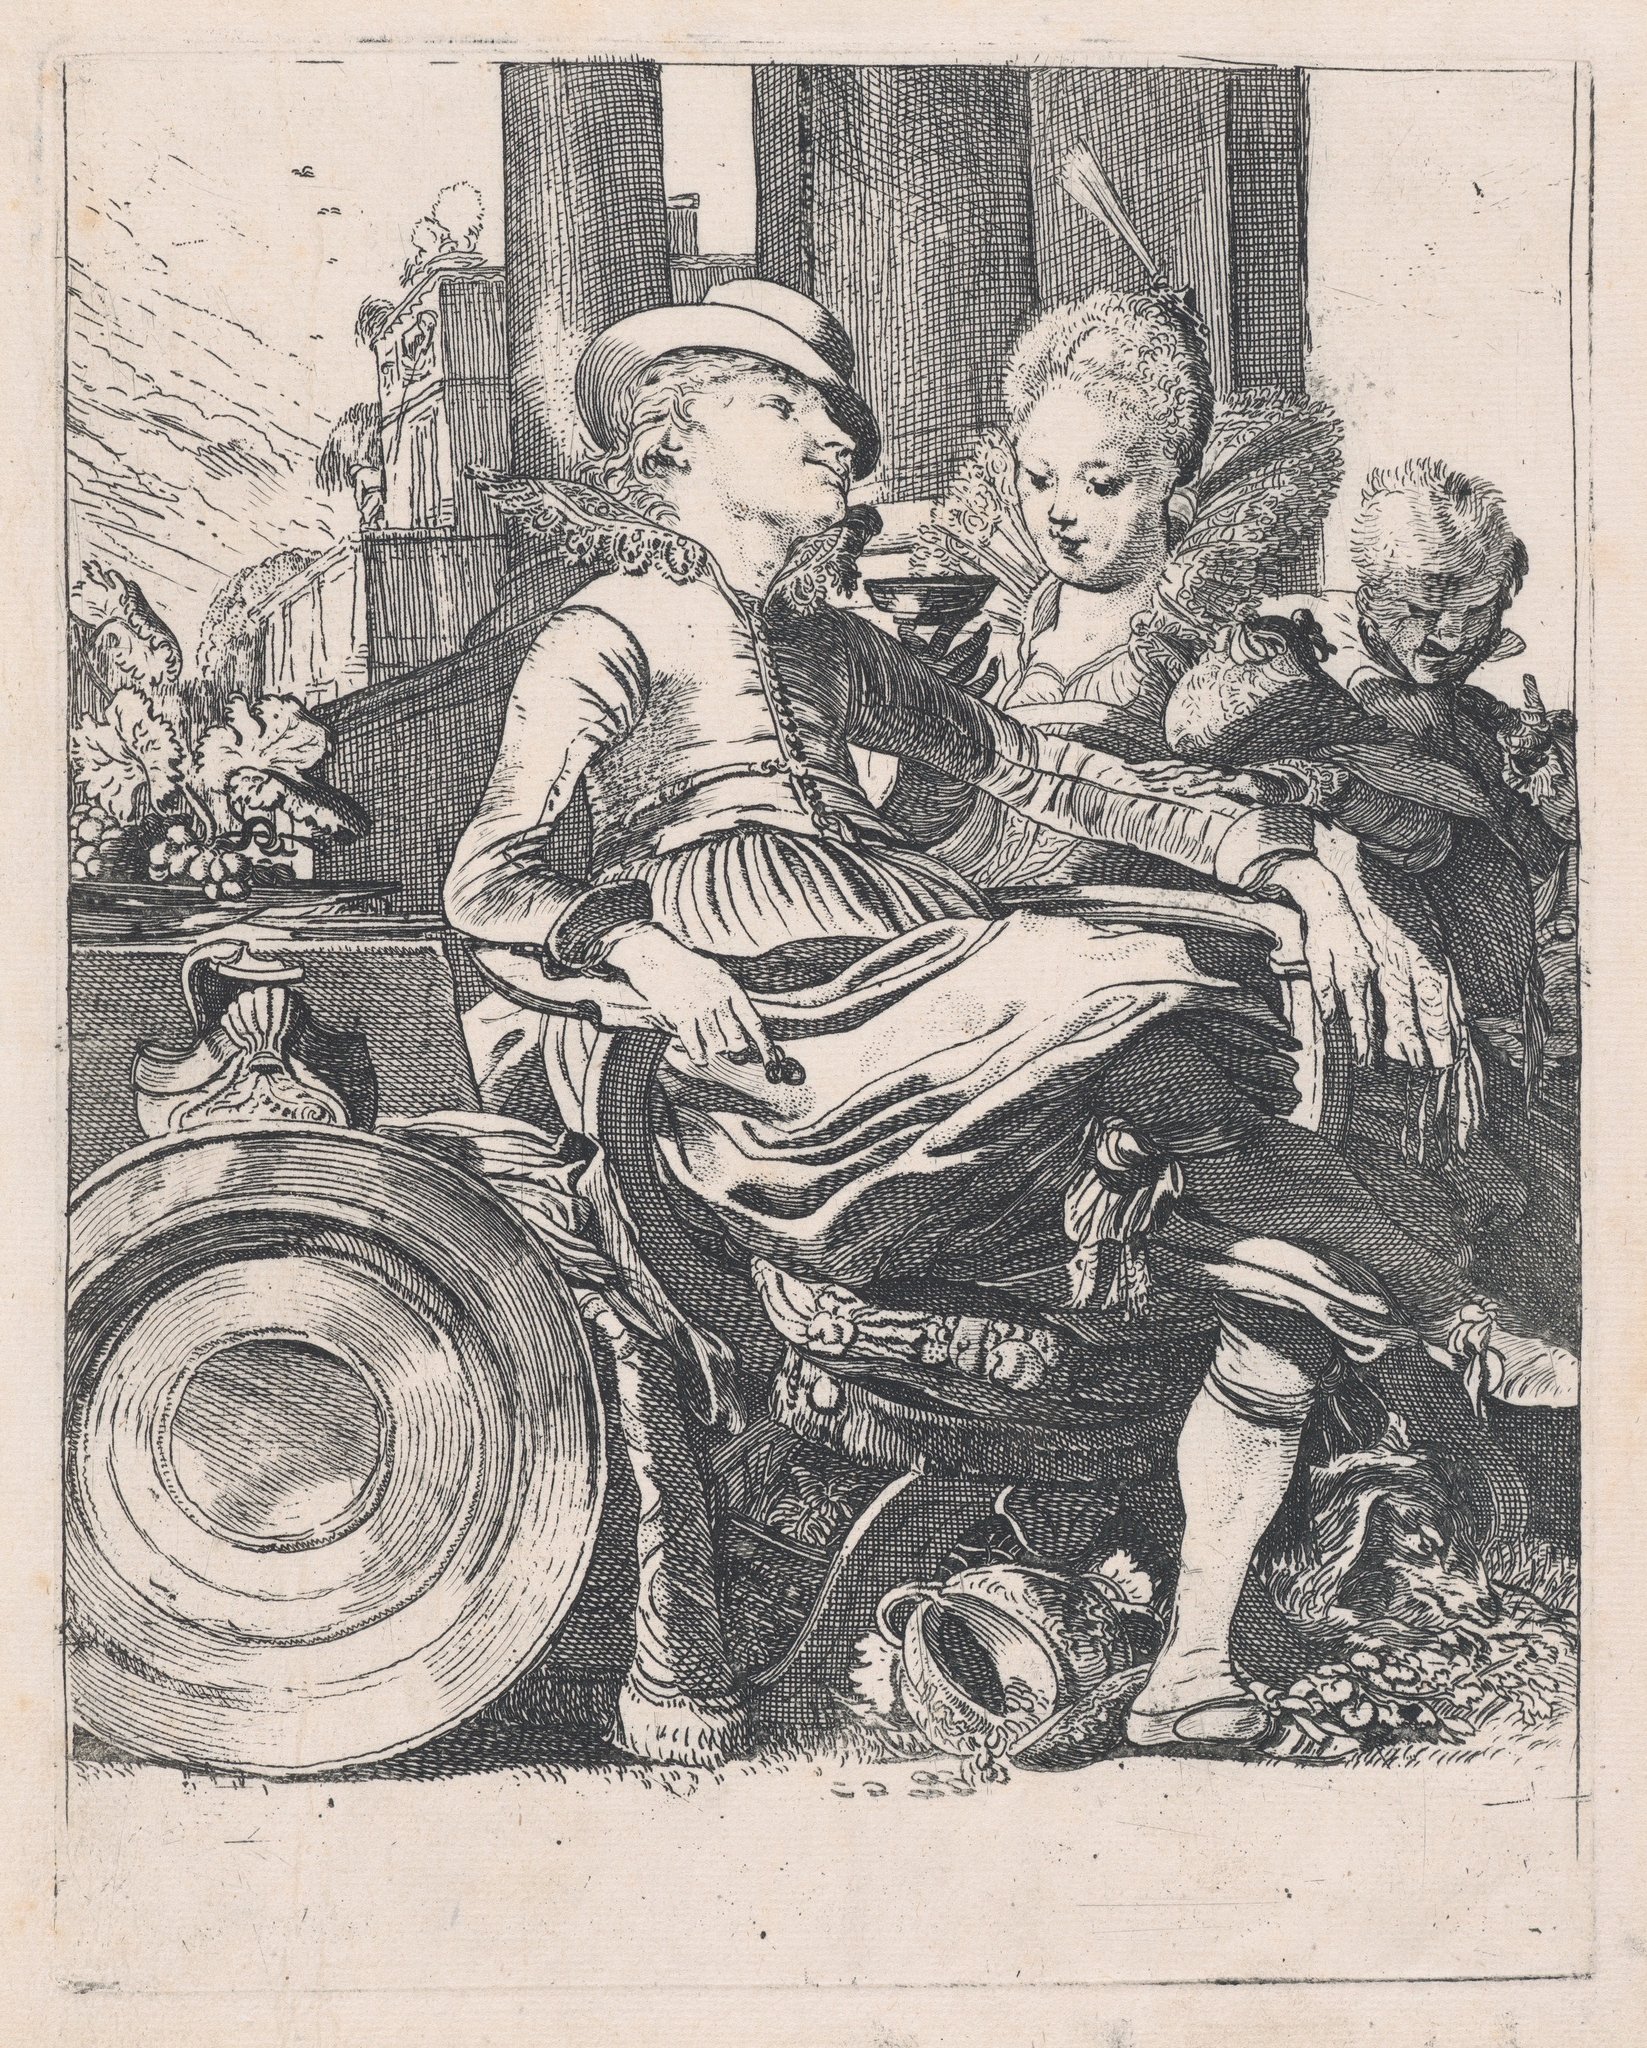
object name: print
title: The Enamored Couple: Lucelle and Ascagnes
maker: willem pietersz buytewech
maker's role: artist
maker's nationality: dutch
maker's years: 1591-1624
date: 1616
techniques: etching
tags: couples,men,women